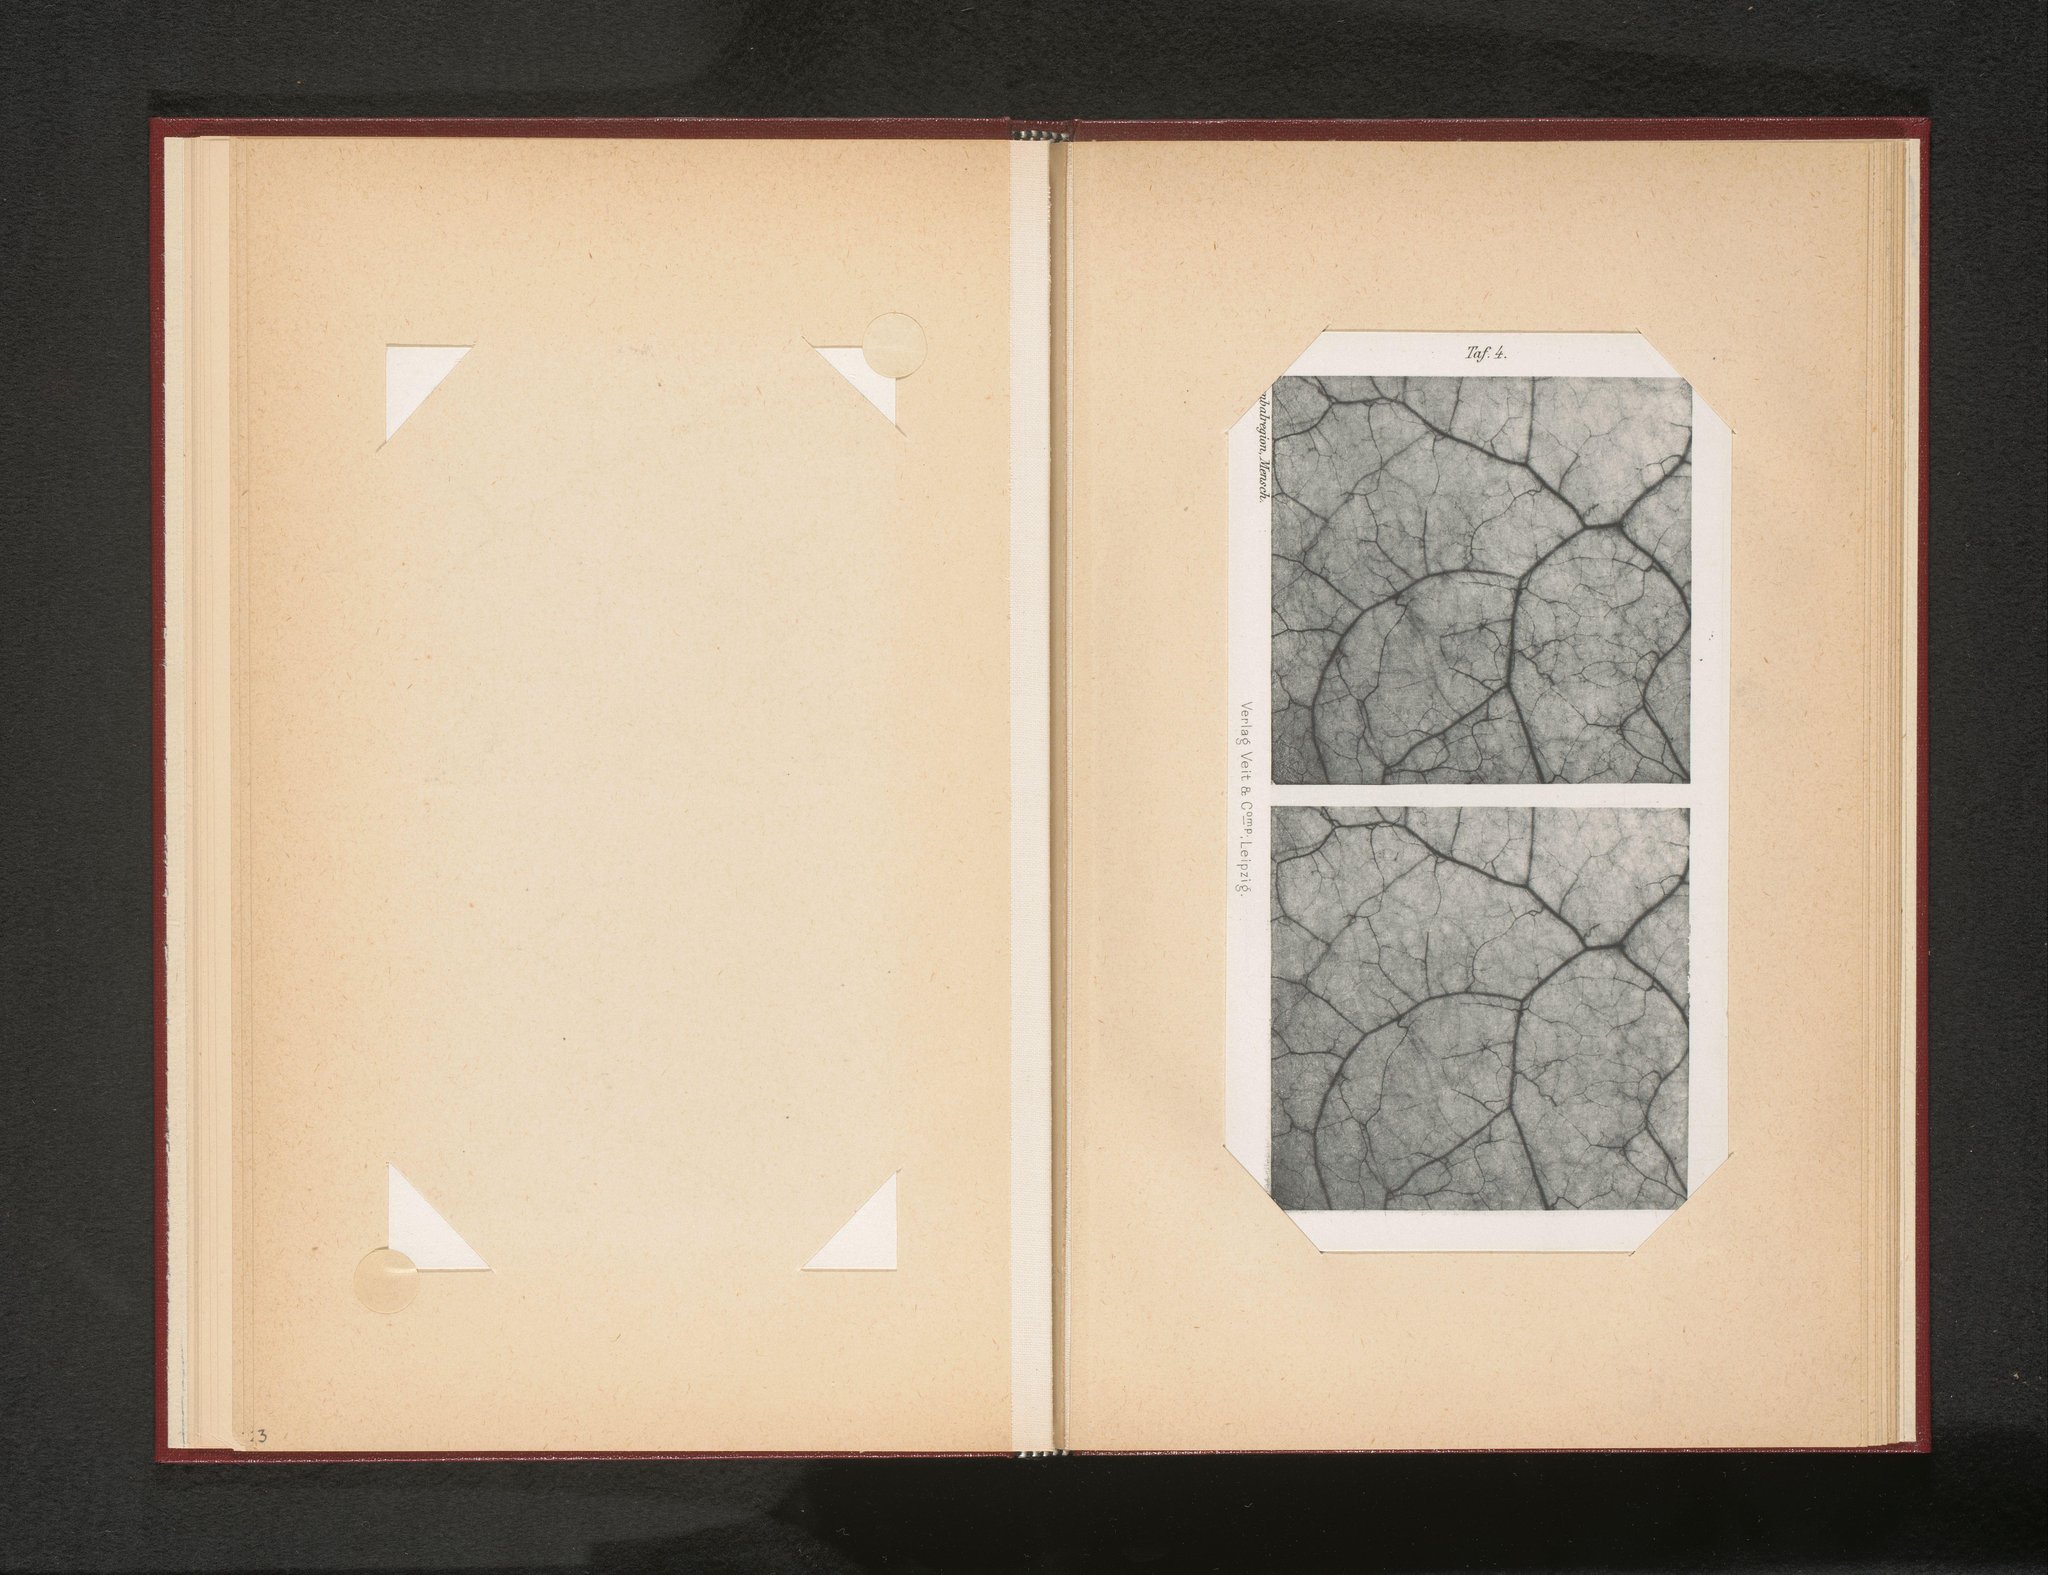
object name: photomechanical print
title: Microscoopopname van menselijke huid van een lende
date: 1885-1895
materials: paper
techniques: photoaquatint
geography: leipzig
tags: skin (human)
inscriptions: number: ‘Taf. 4.’